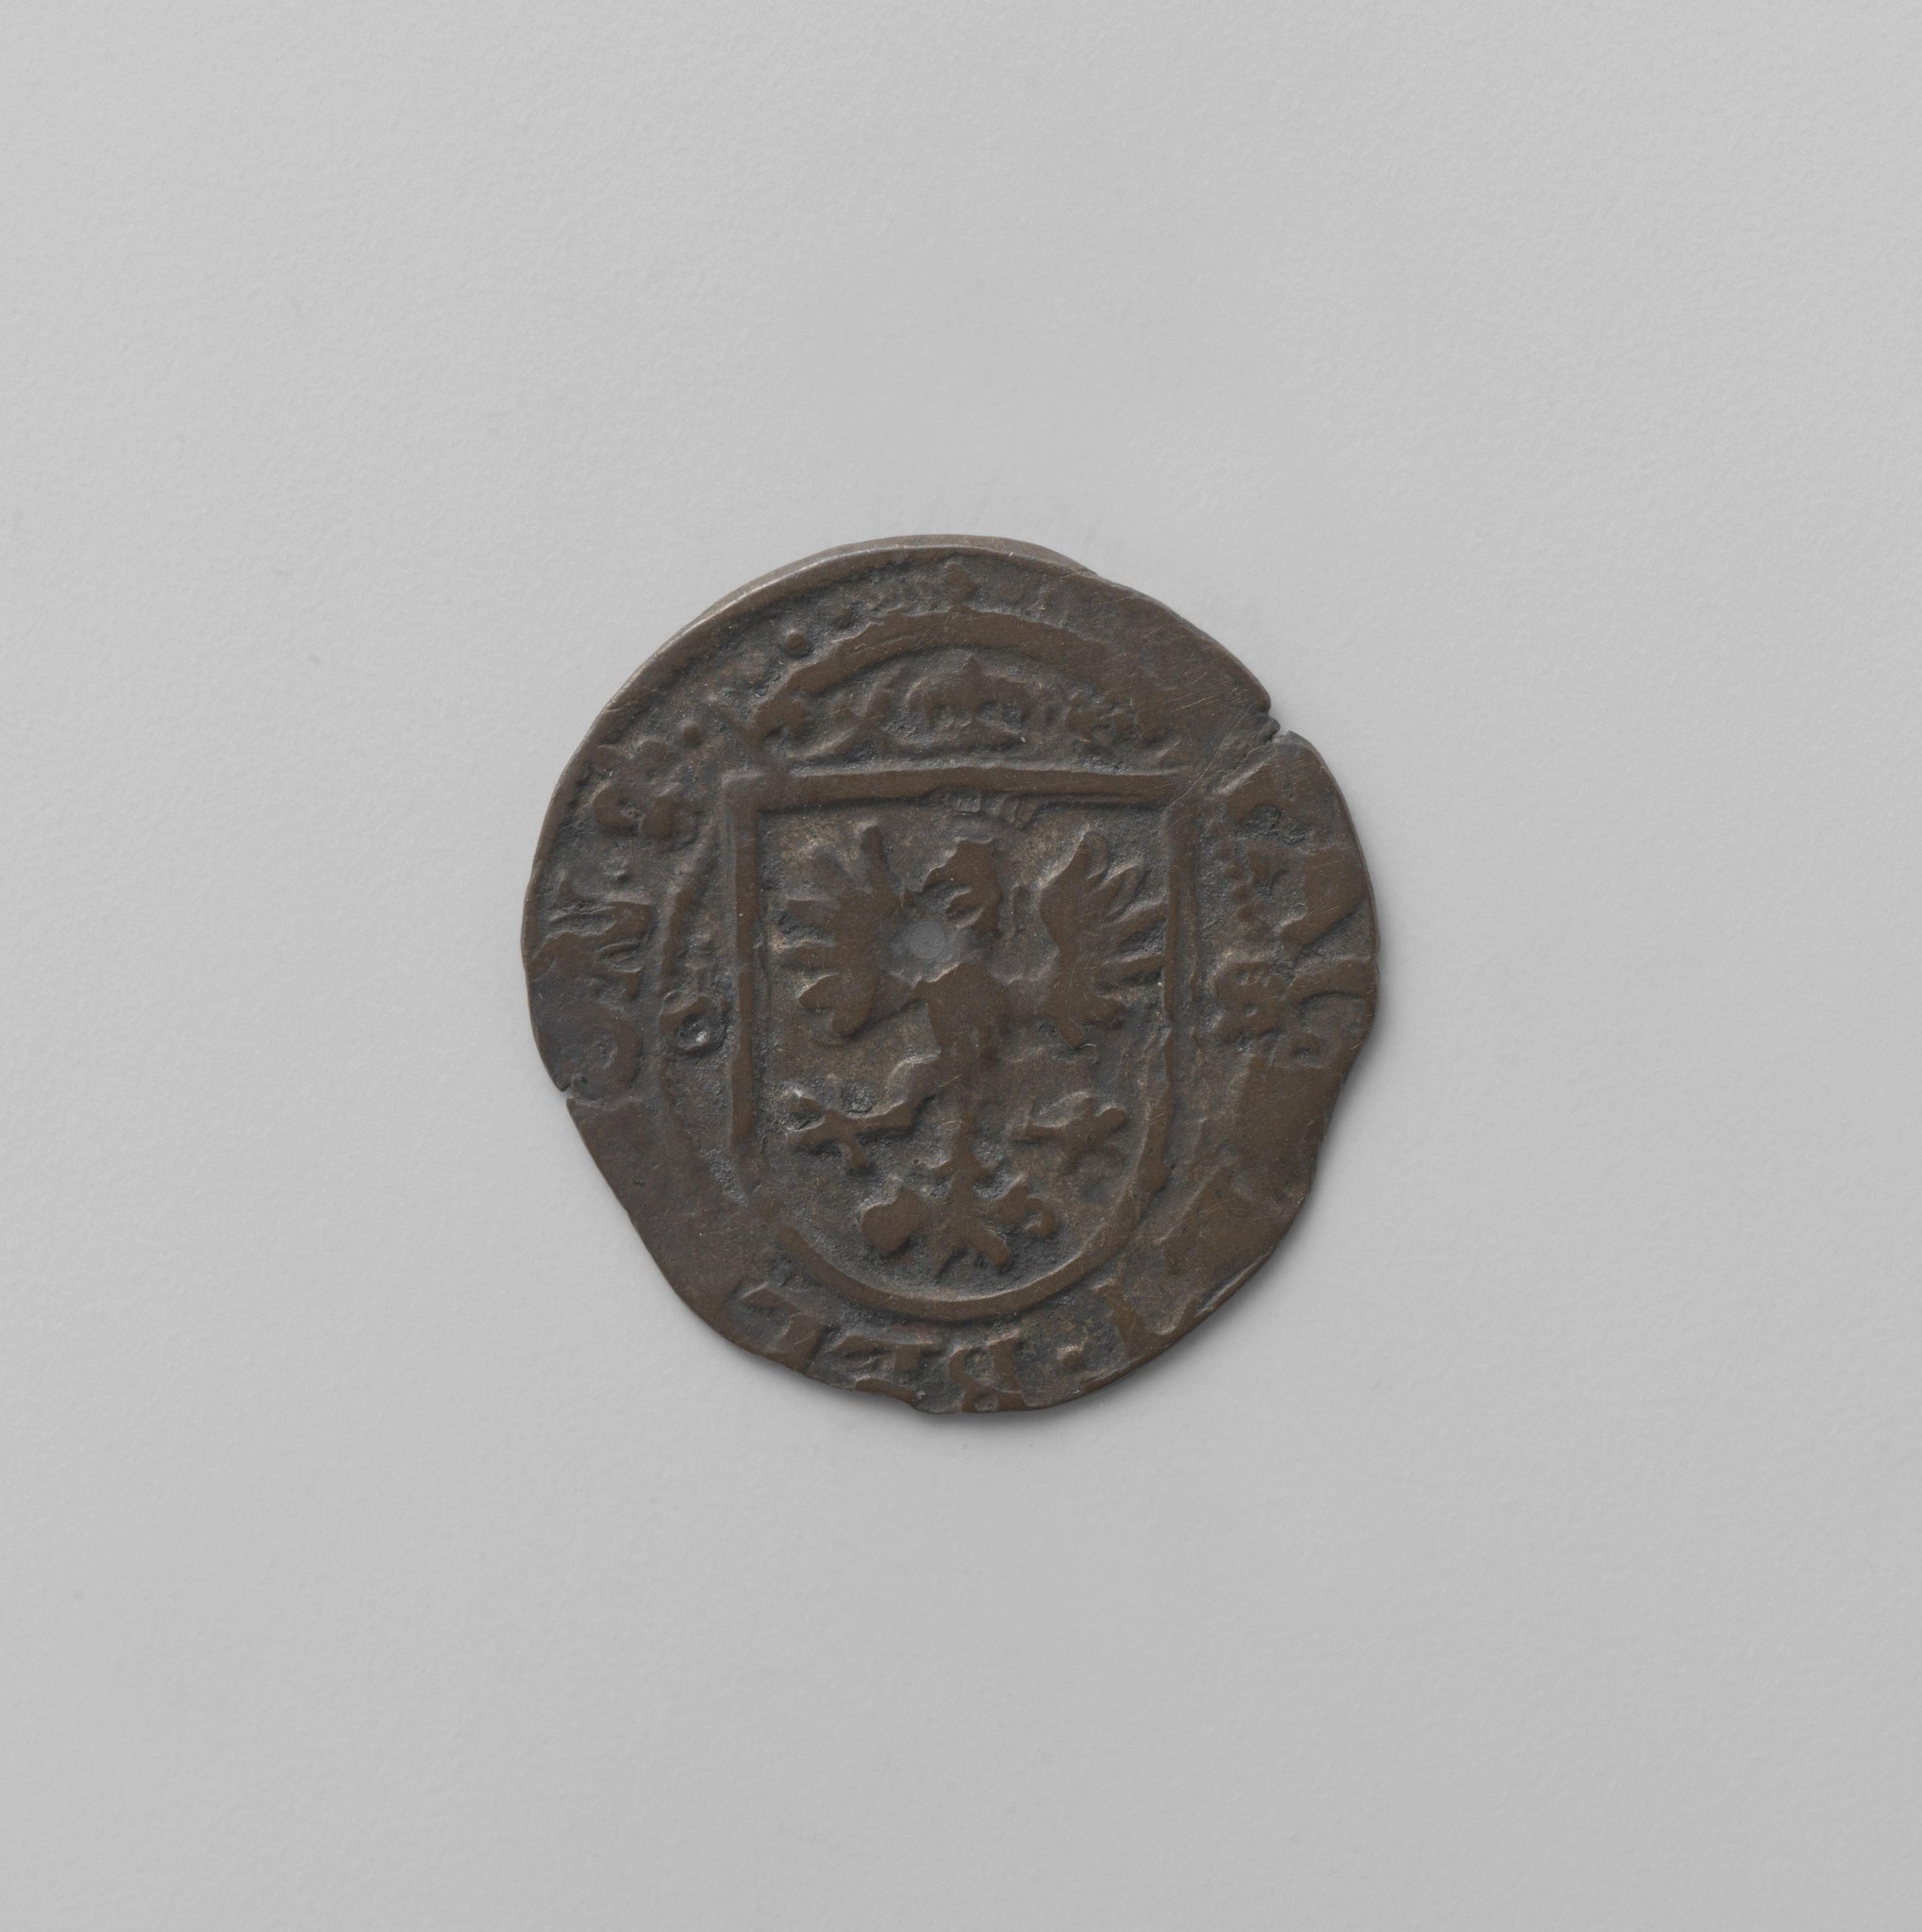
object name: coin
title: Halve stuiver van Deventer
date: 1628-1630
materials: silver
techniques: striking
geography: deventer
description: Zilveren munt. Voorzijde: tussen waarde-aanduiding 1/2 S gekroond wapenschild van Deventer. Keerzijde: lang versierd kruis met in de hoeken letters H, S, D en E.